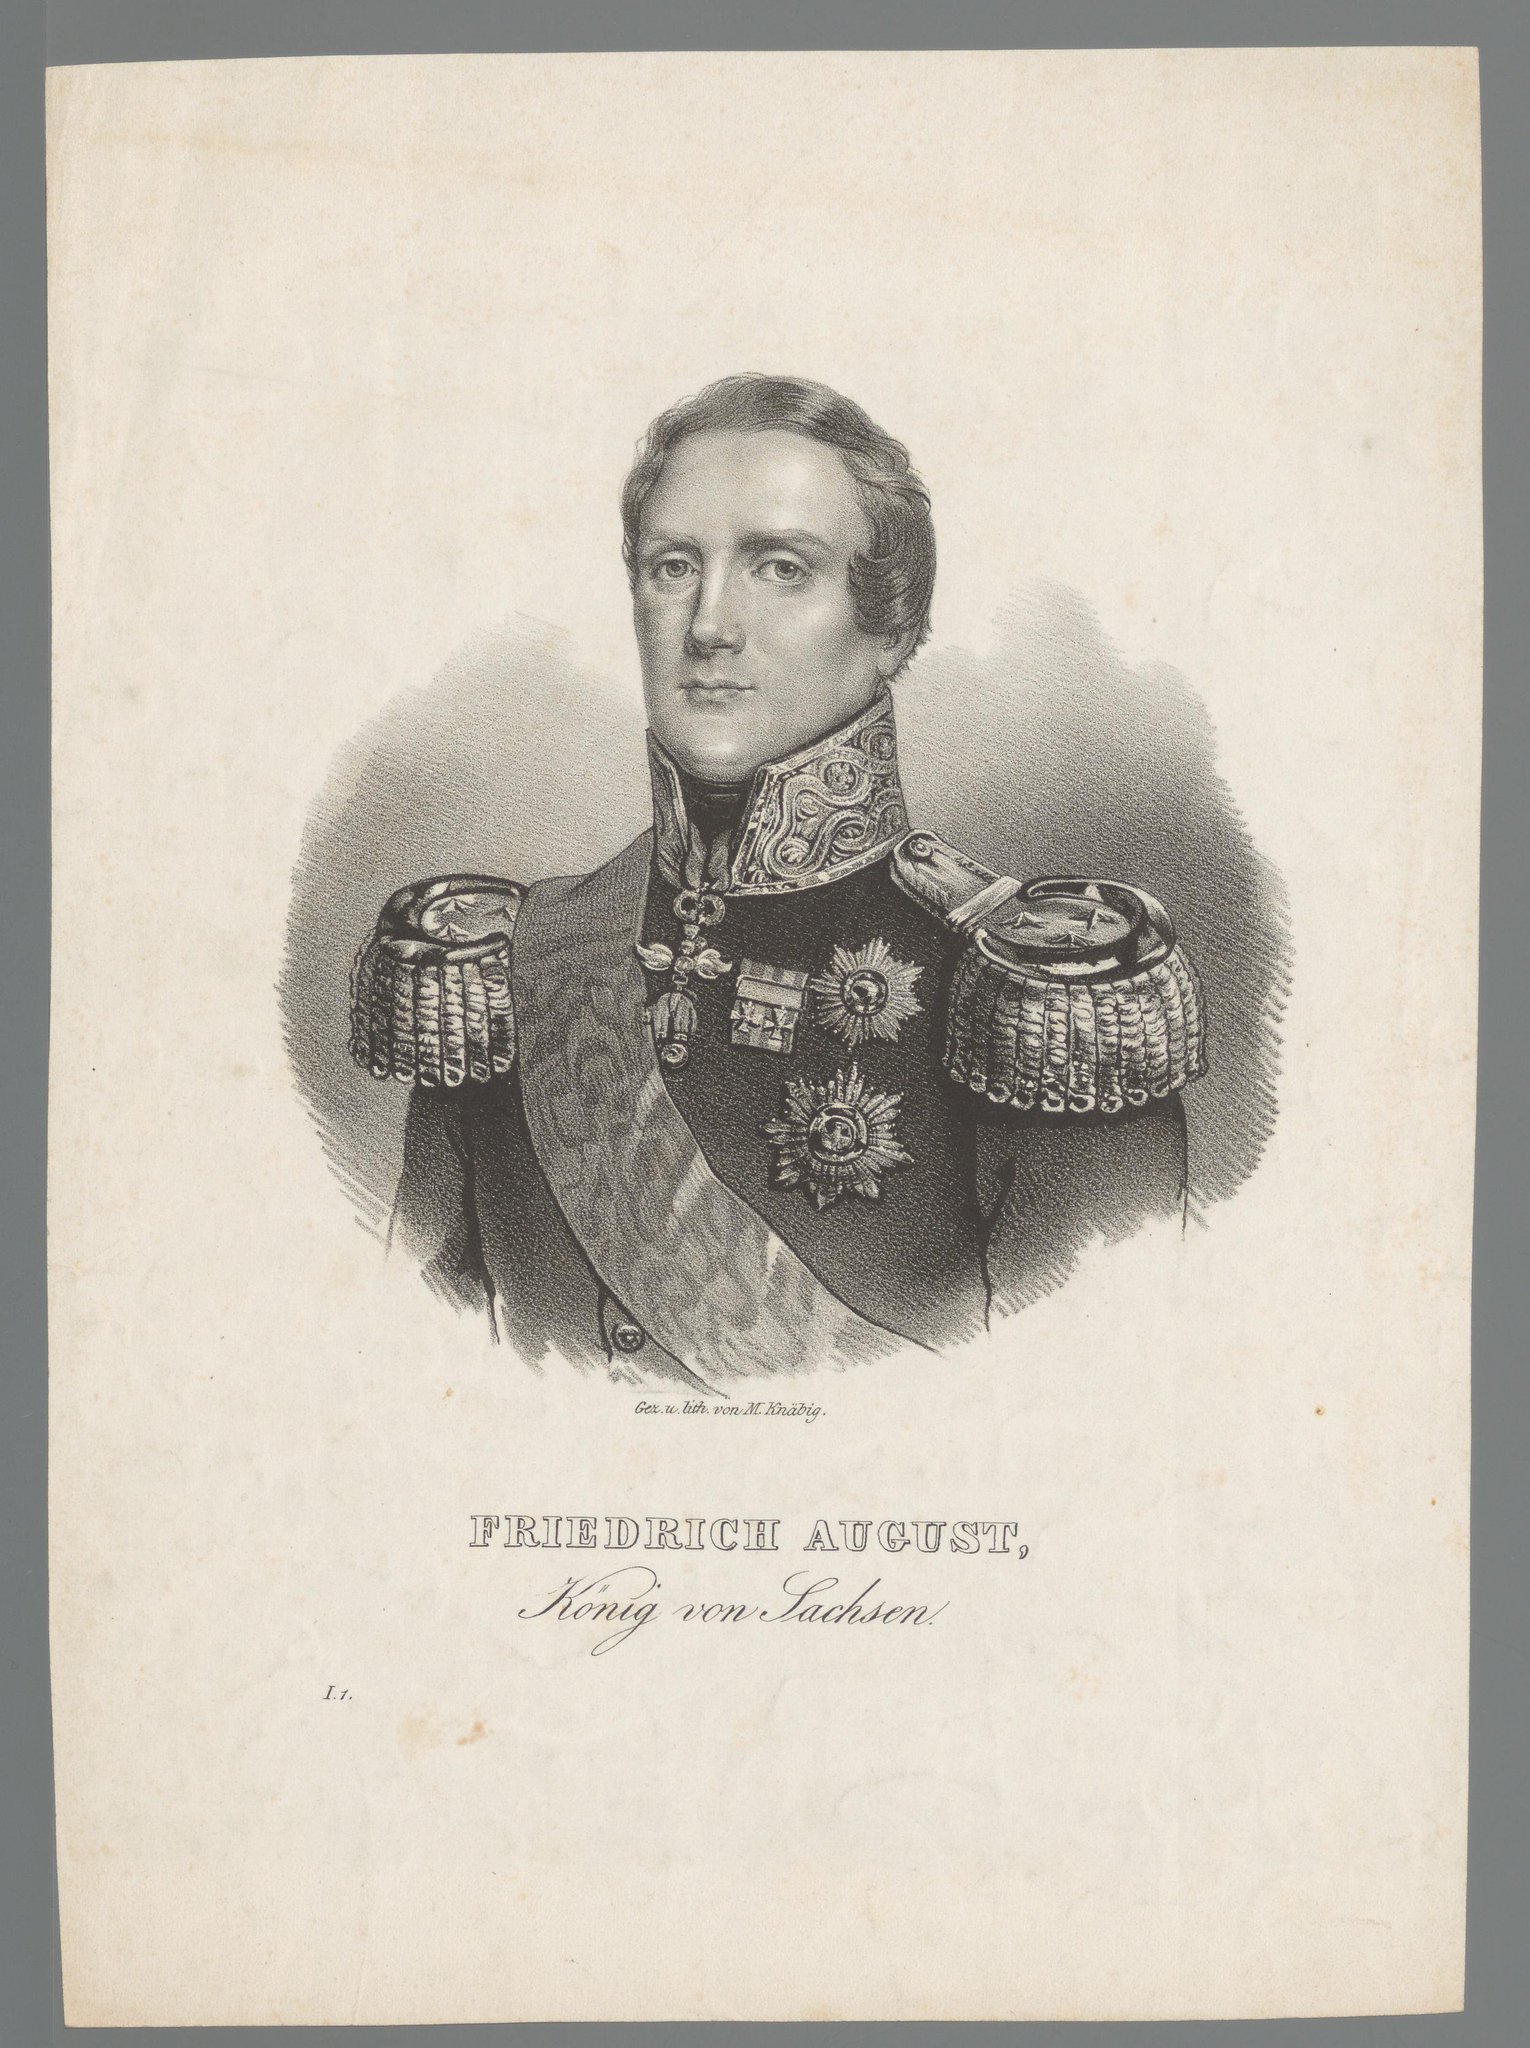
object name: print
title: Friedrich August, König von Sachsen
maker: maximilian knäbig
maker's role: print maker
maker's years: 1804-1876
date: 1814-1876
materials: paper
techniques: lithograph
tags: adult man, historical persons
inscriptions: collector's mark: Lugt 2228